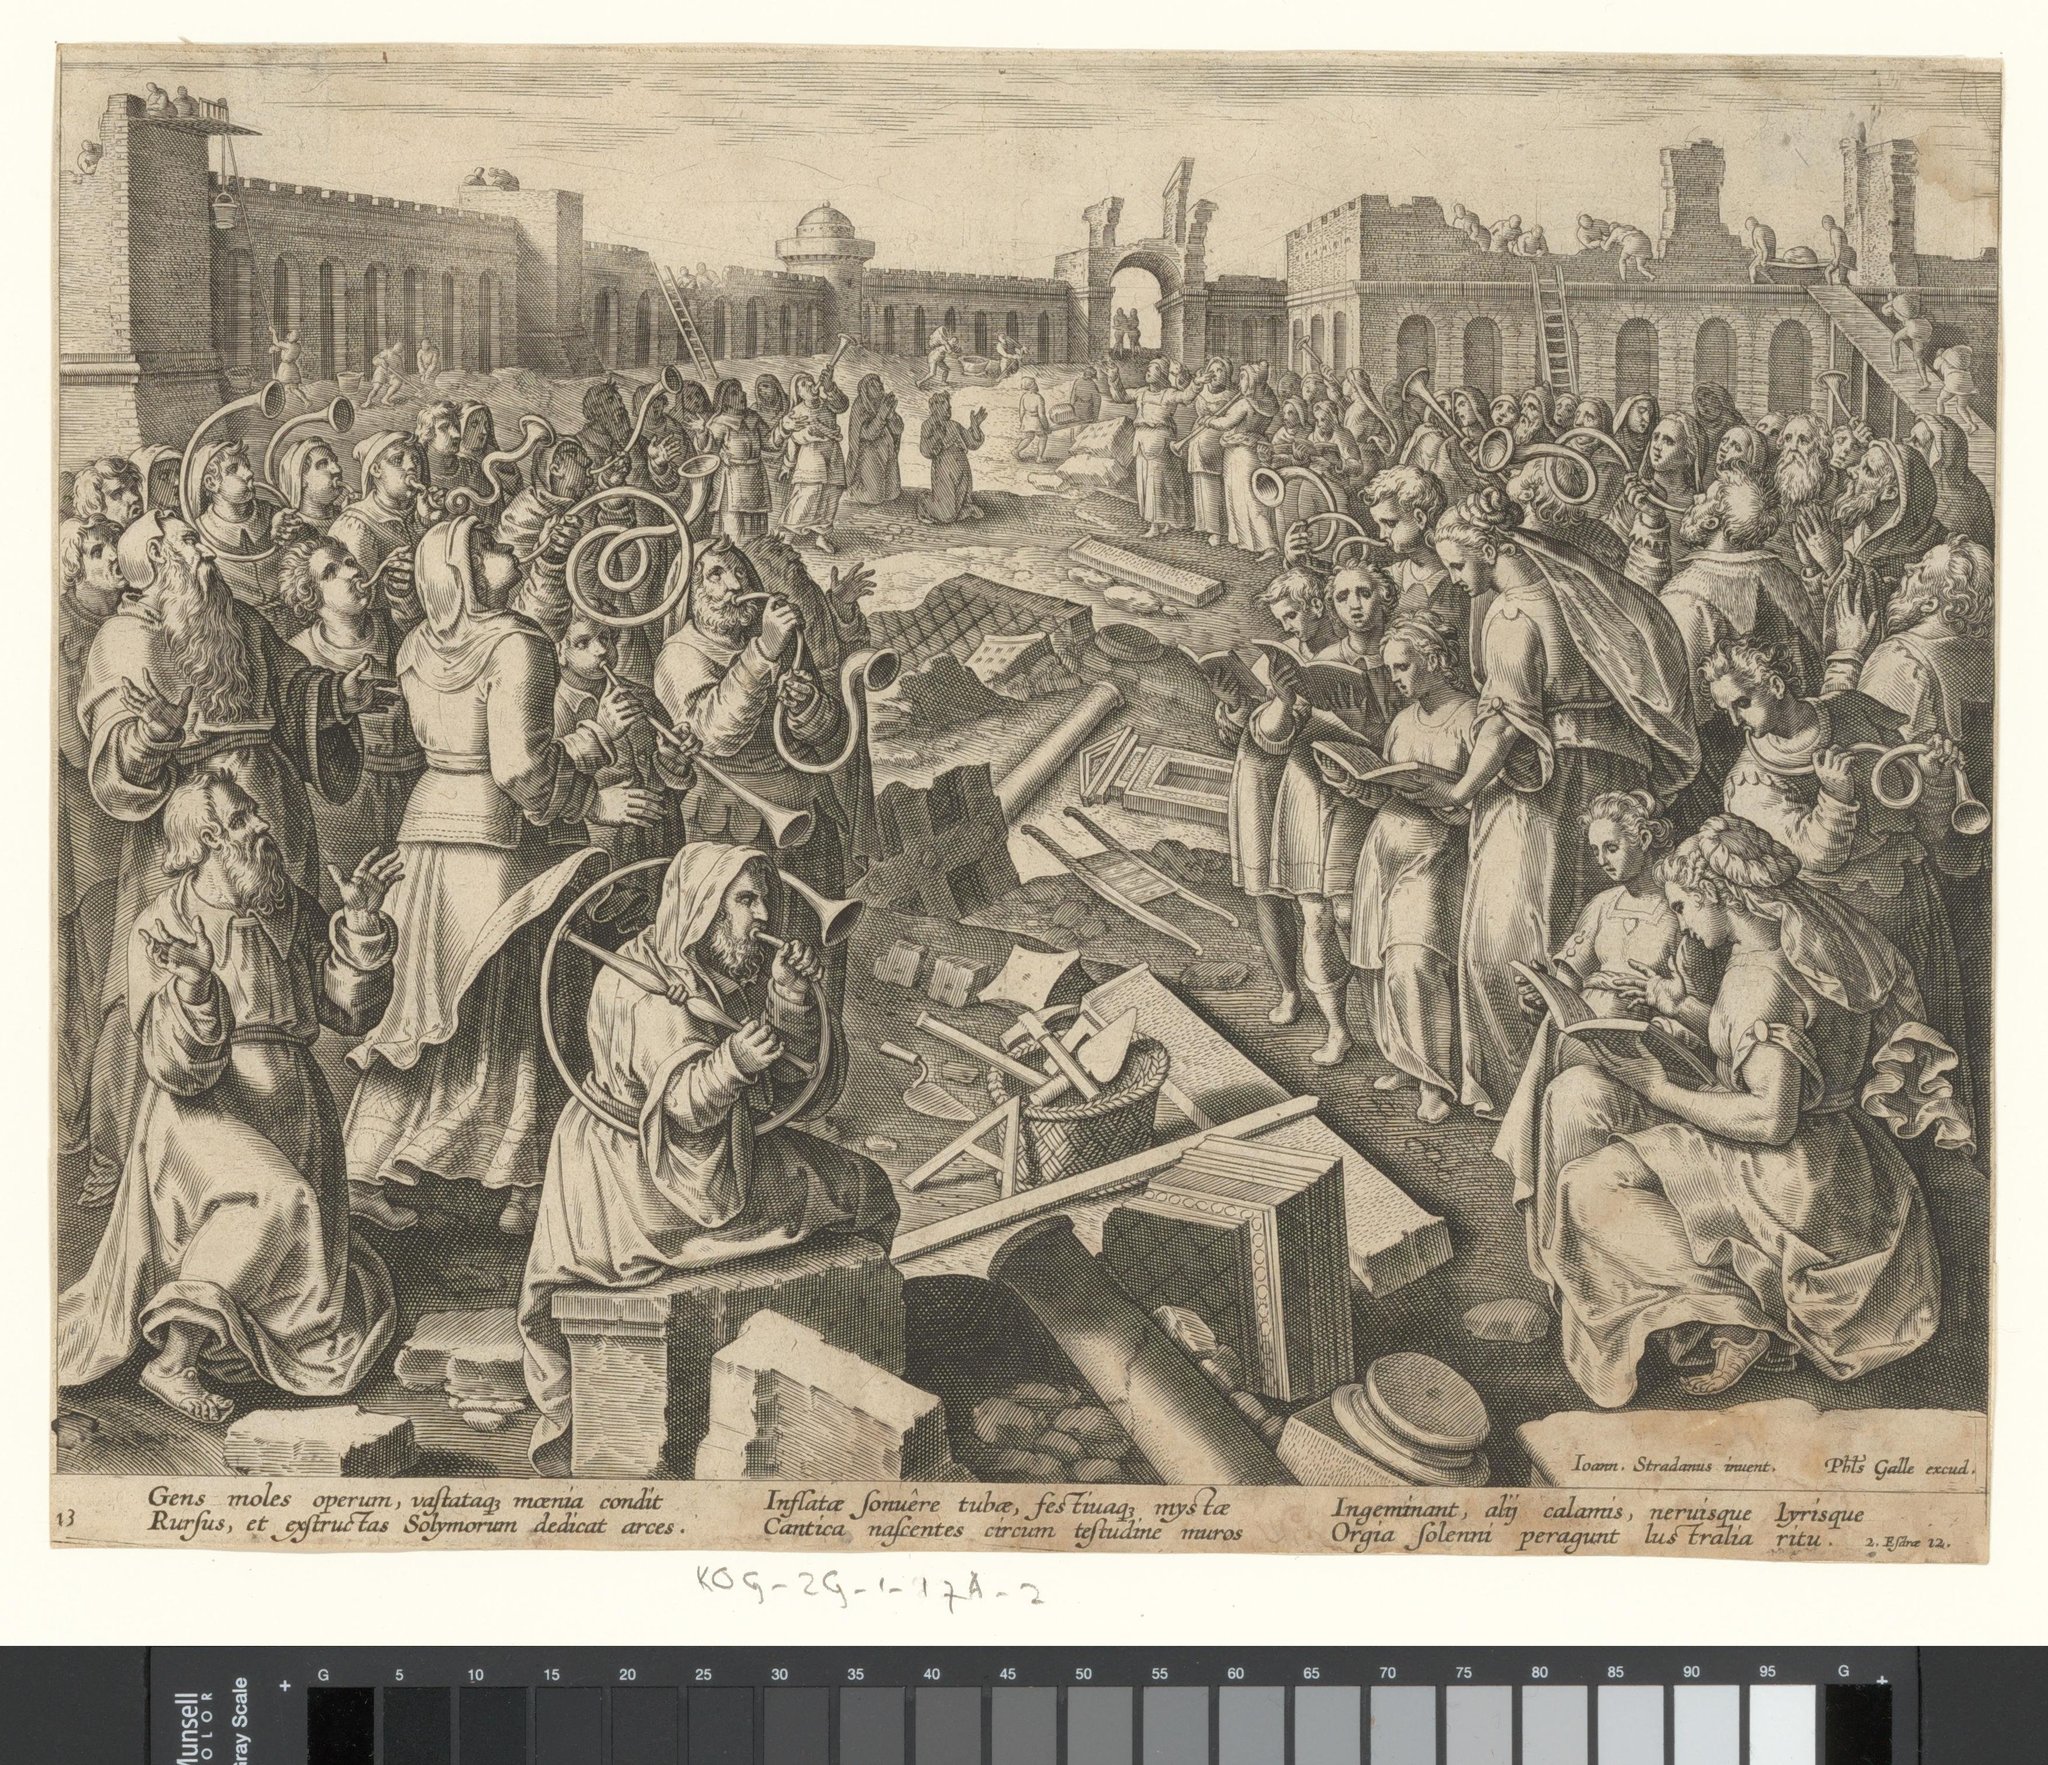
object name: print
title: Inwijding van de fundamenten van de tweede tempel van Jeruzalem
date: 1587-1592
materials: paper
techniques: engraving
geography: antwerp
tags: building activities, musical instruments; group of musical instruments, ceremonies in honour of the completion of the foundation of the temple ~ book of ezra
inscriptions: stamp, collector's mark: Lugt 1641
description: De tempel en de stadsmuren van Jeruzalem worden herbouwd. Tijdens de aanleg van de fundamenten van tweede tempel wordt God geprezen door middel van muziek (hoorns) en zang (Ezra 3:10-12). De prent heeft een Latijns onderschrift met verzen. Linksonder genummerd: 12. Onderwerpsrubrieken binnen de Atlas Zeden en Gewoonten: Muziek en muziekinstrumenten: Muziekinstrumenten op bijbelprenten.